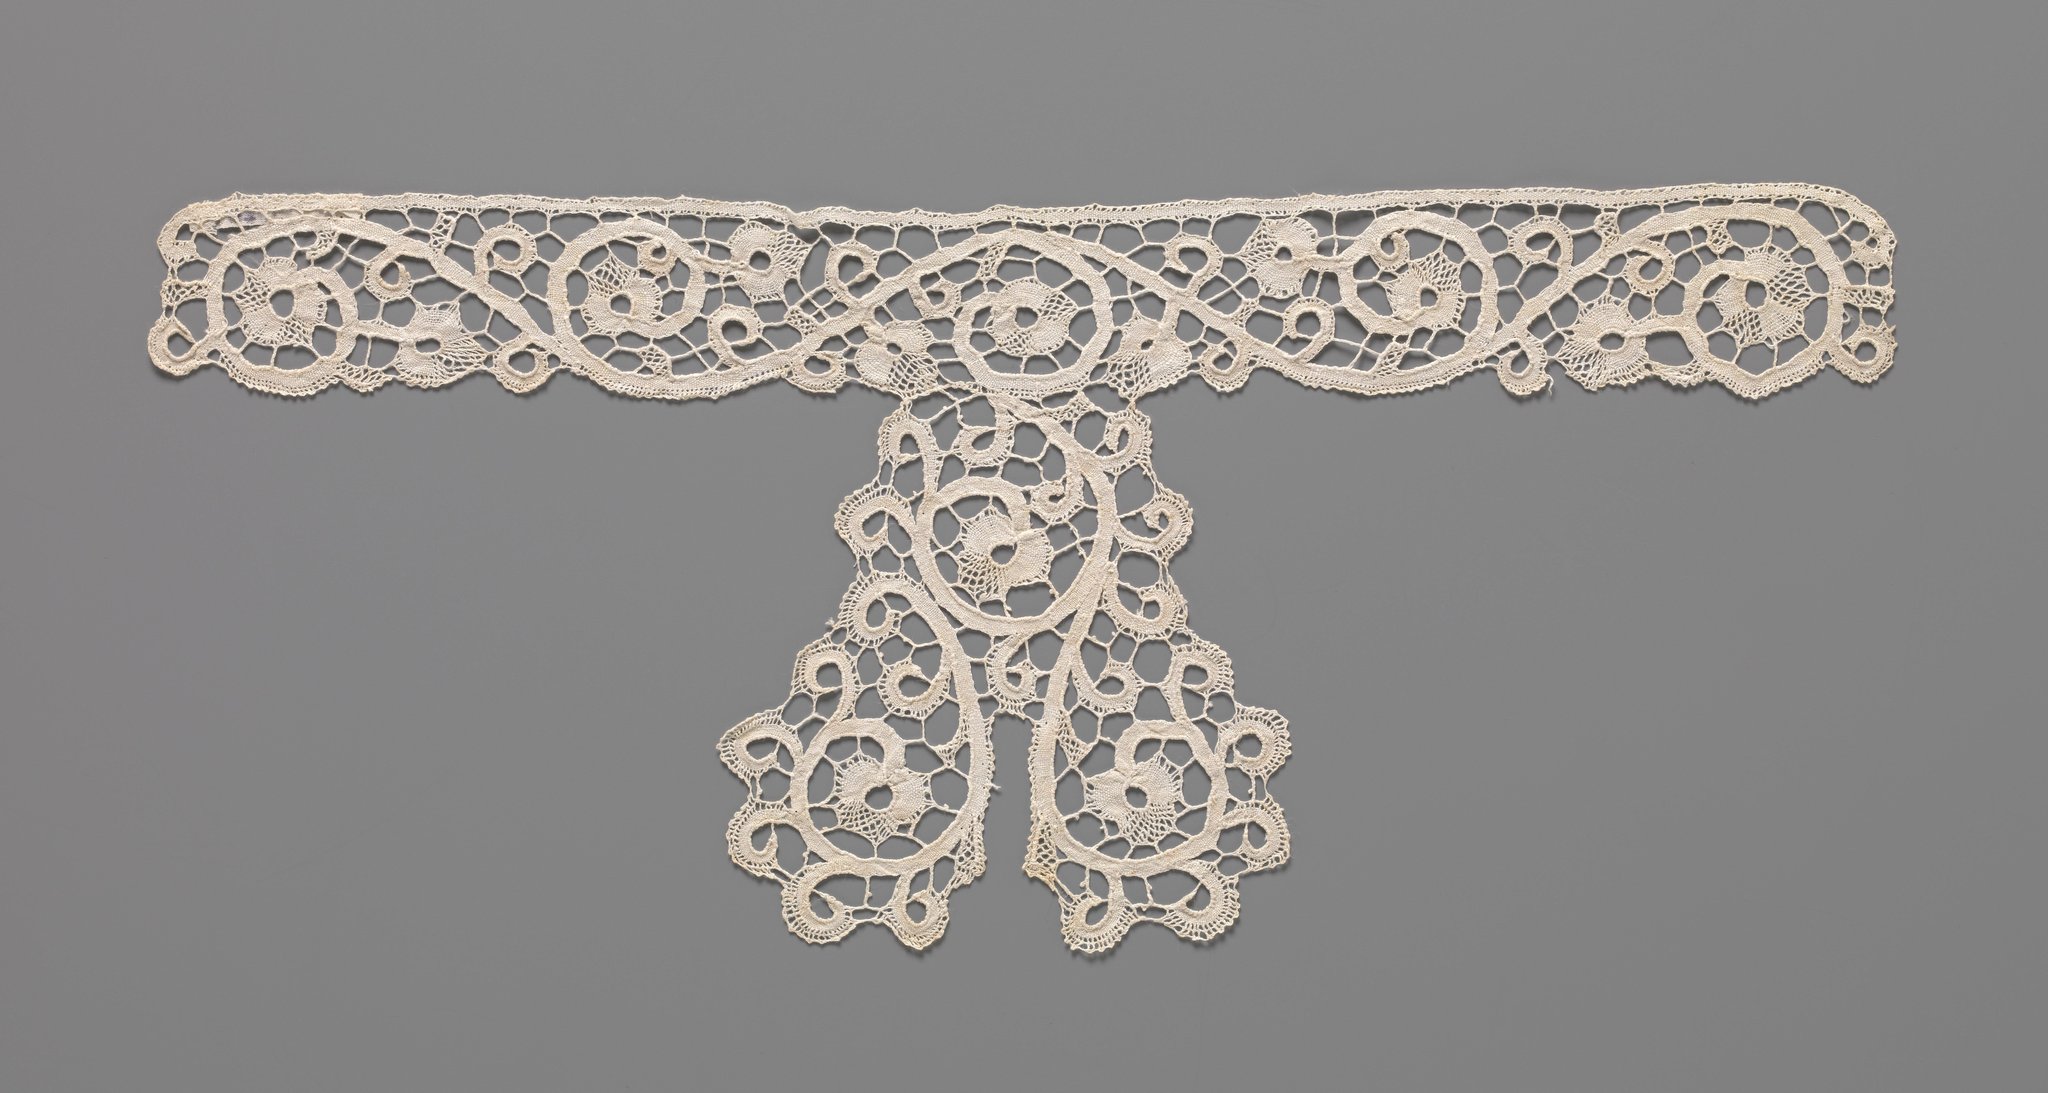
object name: womenswear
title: Kraag met aangehechte jabot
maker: Anonymous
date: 1900-1924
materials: linen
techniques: lace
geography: belgium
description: Kraag met aangehecht jabot van naturelkleurige Venetiaanse kloskant. Strookvormig model waaronder een hartvormig jabot hangt. Het overwegend symmetrische patroon bestaat uit een golvende rank met vijf sterk omkrullende zijtakken met aan elk uiteinde een drie- of vijflobbige bloem. De hartvormige jabot wordt gevormd door drie van zulke omkrullende ranken met dito bloem aan elk uiteinde. Rondom het hart, aan de omkrullende ranken verschillende korte zijtakjes die allemaal dezelfde kant op krullen. De motieven zijn grotendeels gemaakt in linnenslag met hier en daar opengewerkte randjes. Voor enkele (bloem)blaadjes is een andere slag gebruikt. De motieven zijn met elkaar verbonden door vlechtjes. De bovenzijde van het geheel is recht afgewerkt. De omkrullende ranken en zijtakjes vormen een schulpenrand langs de overige randen.